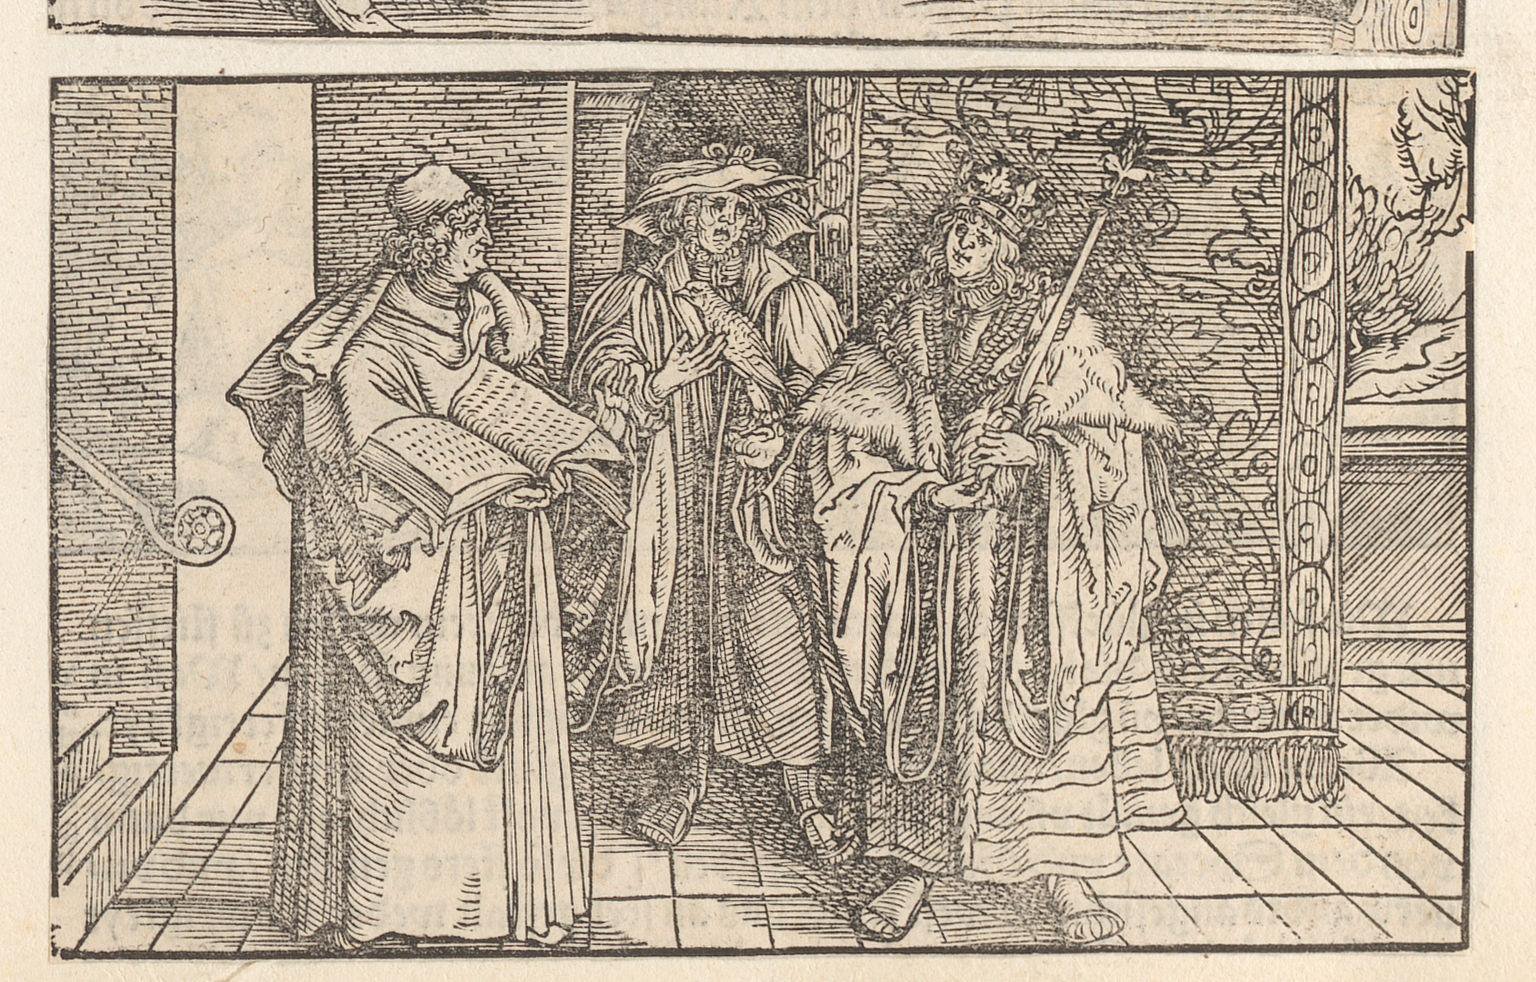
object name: album leaf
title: Geleerde met een boek, koning met een scepter en pelgrim met een valk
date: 1514-1531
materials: paper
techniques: letterpress printing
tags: pilgrim(s), wise man, king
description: Deze prent is gebruikt in: Cicero, Marcus Tulius. Officia M.T.C. Ein Buch so Marcus Tullius Cicero der Römer zu seynem (...). [Vertaald uit het Latijn door] Johann von Schwarzenberg. Augsburg: Heinrich Steiner, 1531.